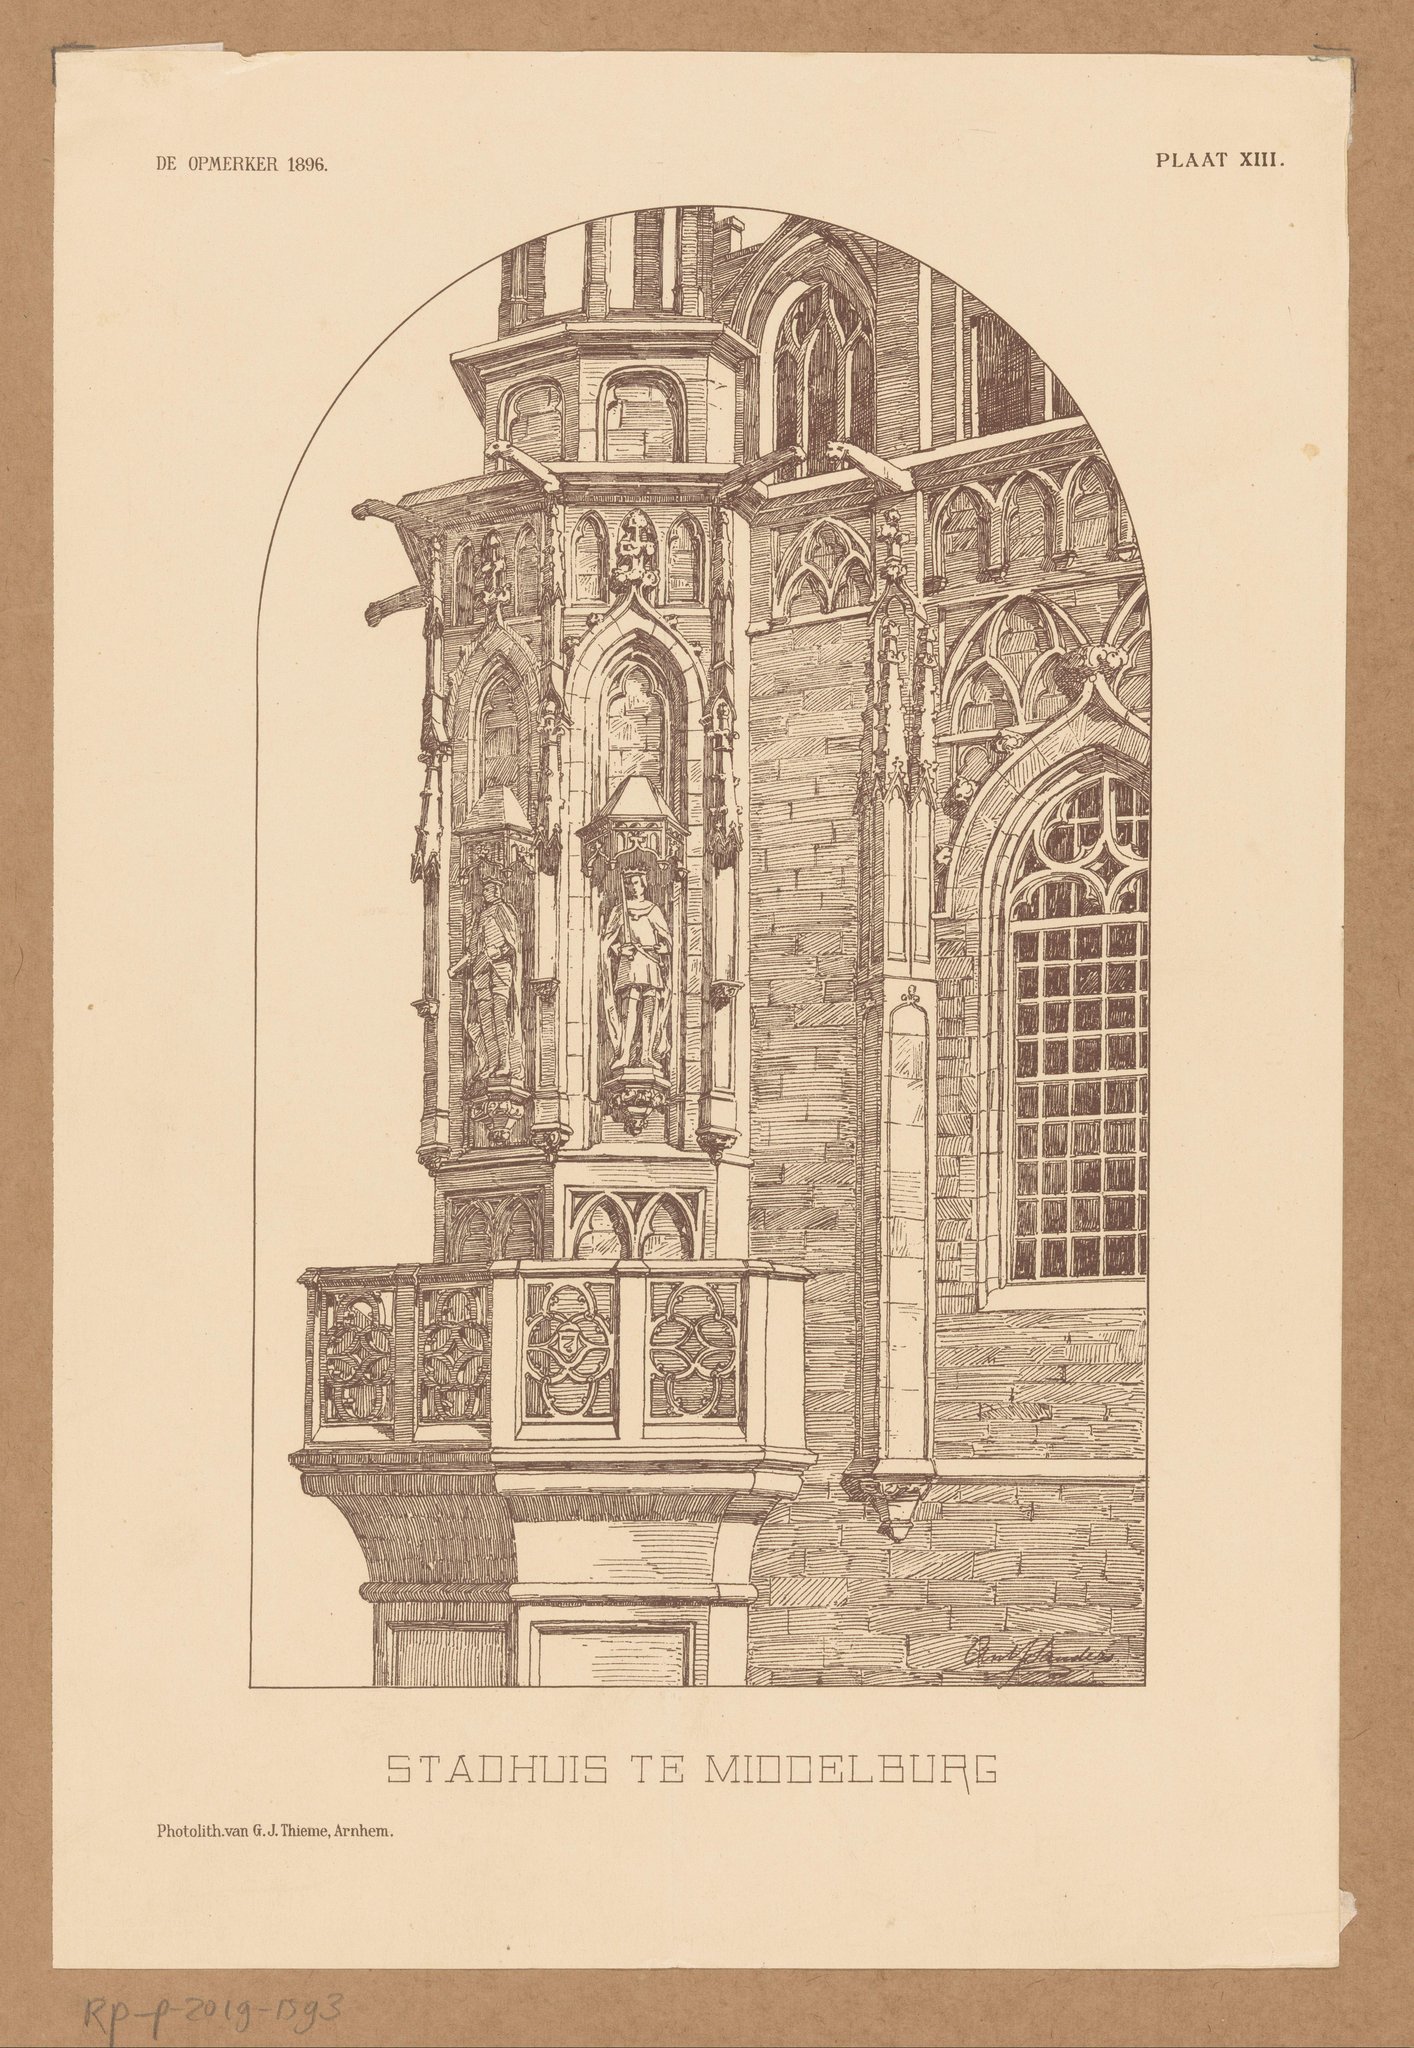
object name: book illustration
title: Stadhuis te Middelburg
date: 1896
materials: paper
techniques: photolithography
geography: the hague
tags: architectural detail, townhall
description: Afdruk uit: De Opmerker. Bouwkundig Weekblad, 18 juli 1896, tussen p. 230 en 231.